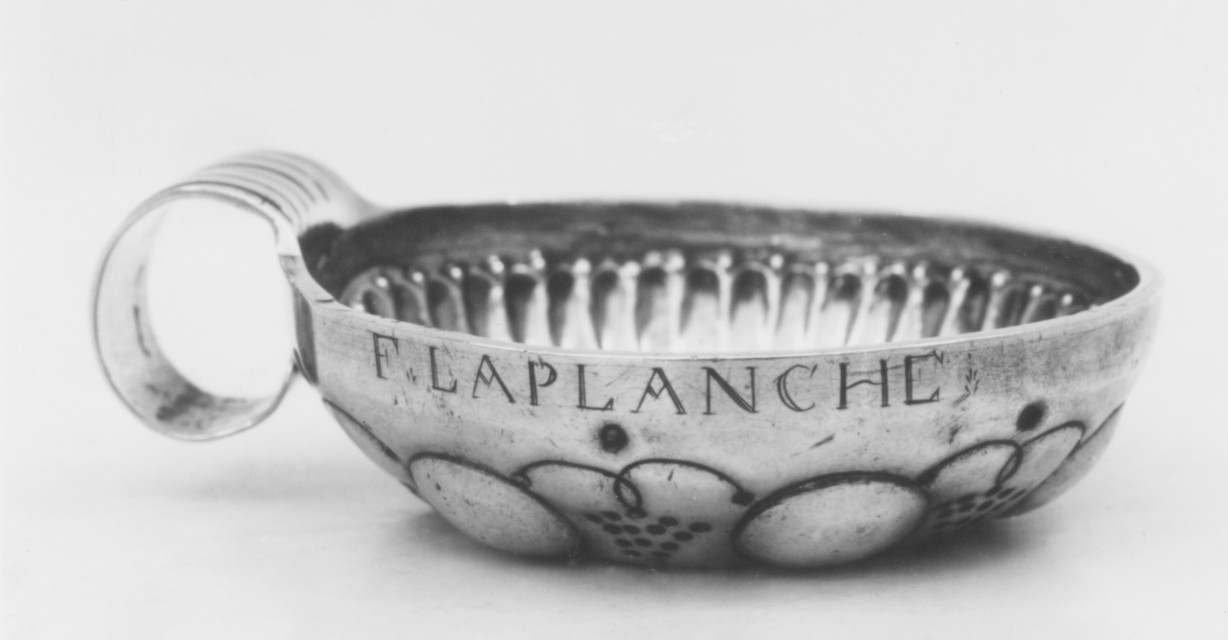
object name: wine taster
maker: b.n. gravillon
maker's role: maker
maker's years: 1798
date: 1819-1838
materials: silver